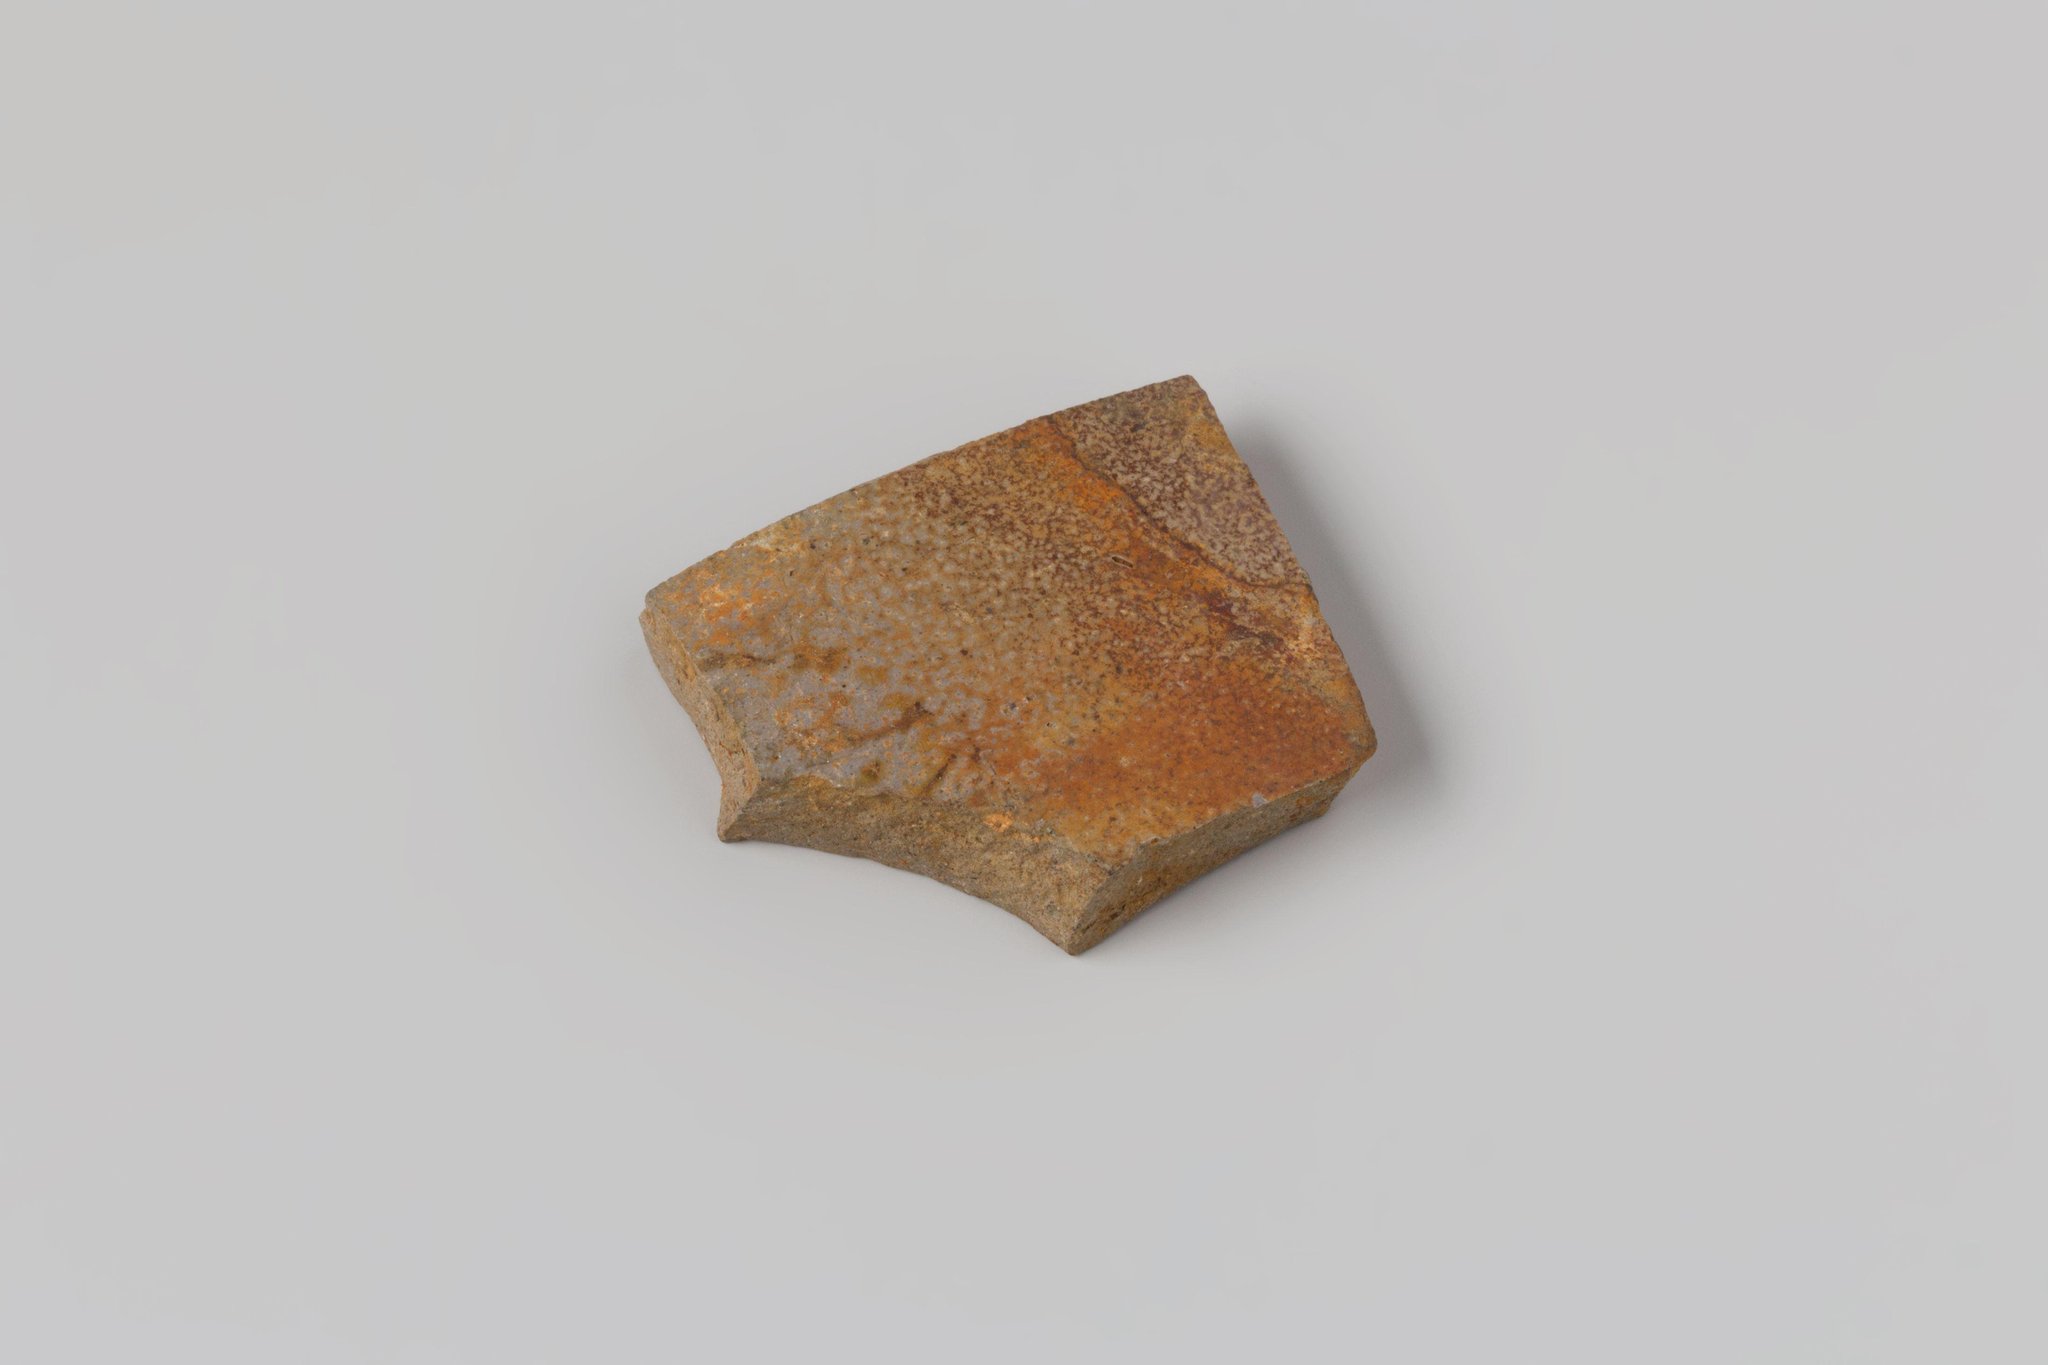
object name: ewer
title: Scherf van een kan uit het wrak van de Oost-Indiëvaarder Hollandia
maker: Anonymous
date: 1700-1743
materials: stoneware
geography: cologne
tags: verenigde oostindische compagnie, hollandia (schip), annet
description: Stoneware, Rhenish, Frechen-ware, jug; fragm of body.